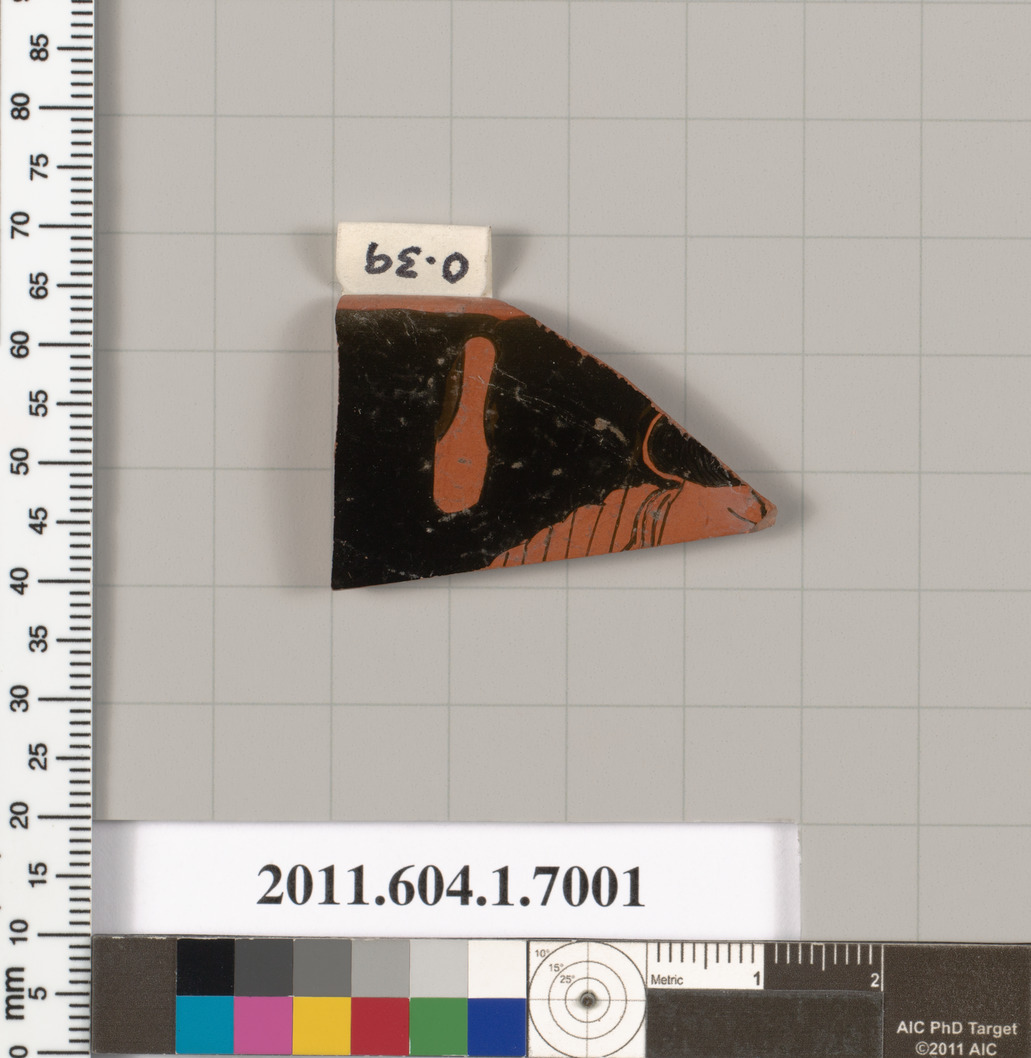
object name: kylix fragment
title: Terracotta rim fragment of a kylix (drinking cup)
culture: greek, attic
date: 500-480 BCE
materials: terracotta